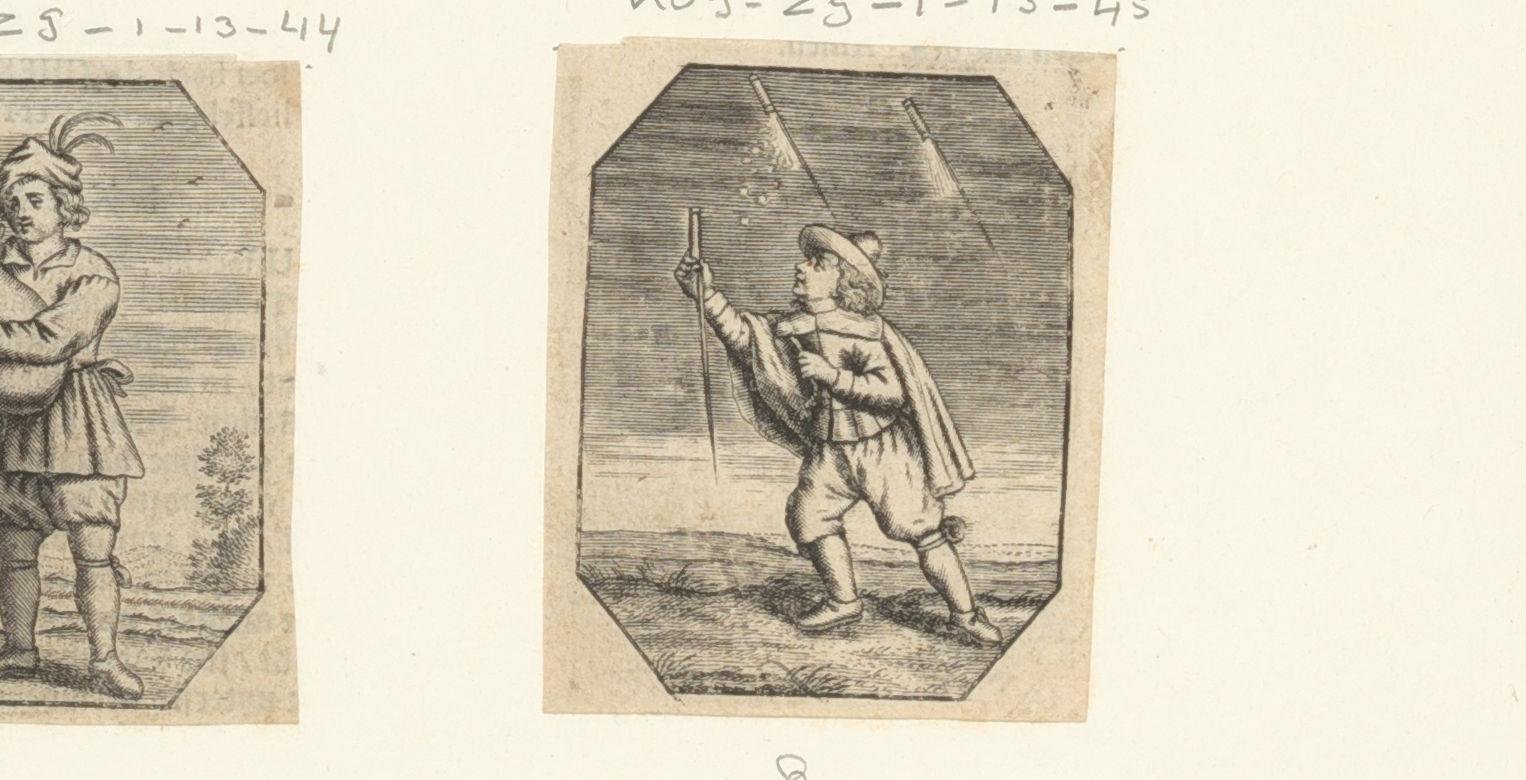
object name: print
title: Man steekt vuurwerk af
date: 1667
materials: paper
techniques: engraving, letterpress printing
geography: antwerp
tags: handicrafts, craftsman at work, bonfire, fire-works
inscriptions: stamp, collector's mark: Lugt 1641a, collector's mark: Lugt 1641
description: Prent uit: Smidt, Gilles de. Den wegh der devghden, voor de beghinnende, voort-gaende, ende volmaeckte ghemaeckt. Antwerpen: Michiel Cnobbaert, 1667, p. 109.